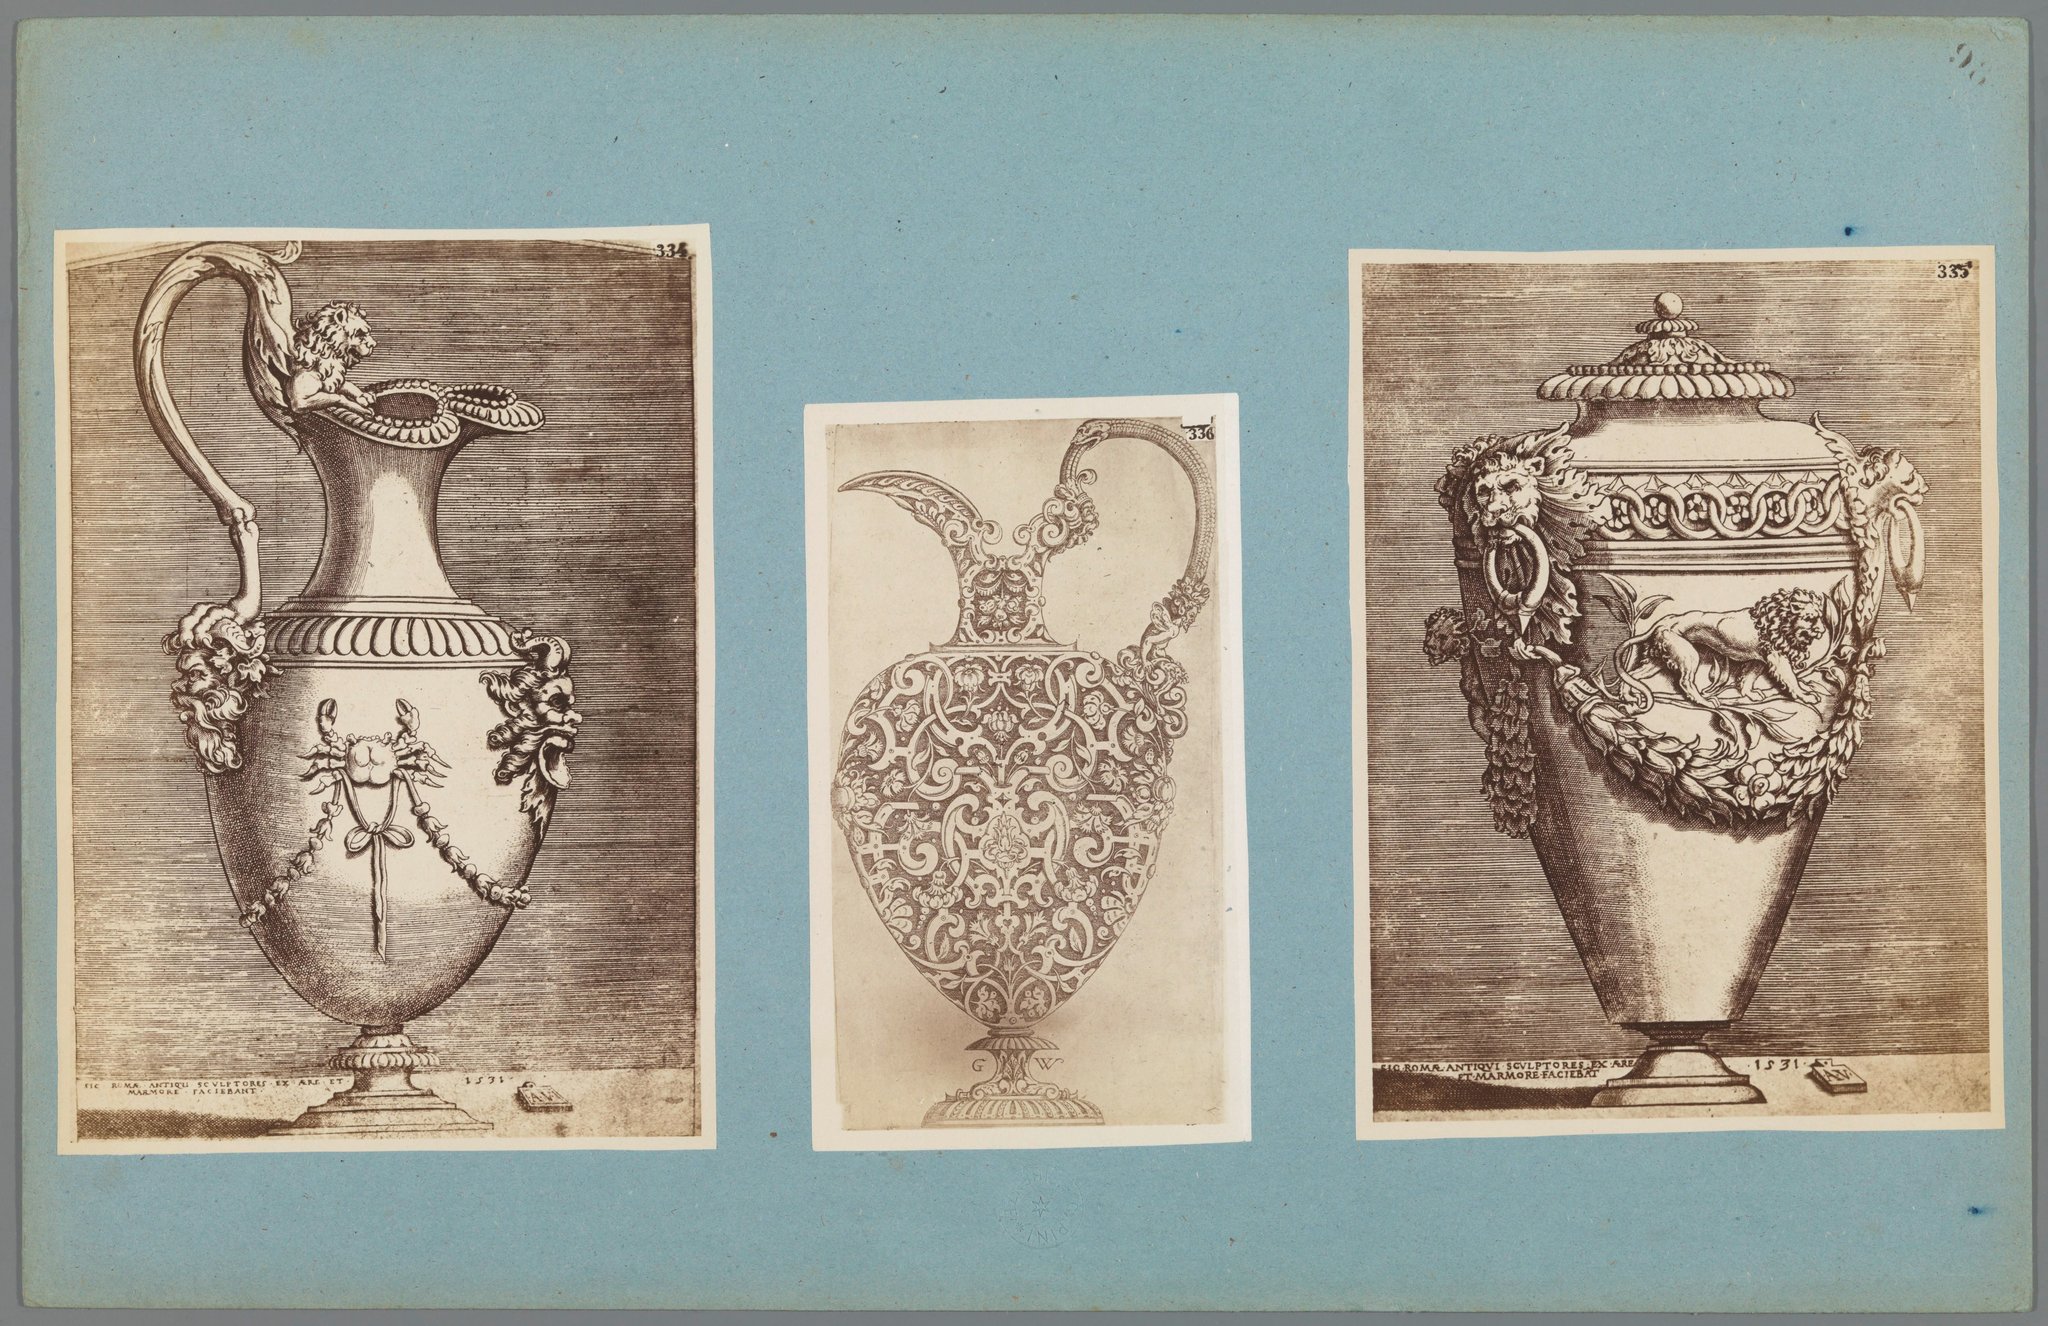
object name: reproduction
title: Drie fotoreproducties van prenten van vazen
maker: Anonymous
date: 1875-1900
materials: cardboard, photographic support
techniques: albumen print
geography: europe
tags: fantasy ornament, vase ~ ornament, crustaceans: crab, beasts of prey, predatory animals: lion, europe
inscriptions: number: ‘98’, number: ‘335’, collector's mark: Lugt 3937, number: ‘336’, name: ‘C. PINI FIRENZE’, number: ‘334.’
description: Links (334) een prent van een vaas met een leeuw en een krab, midden (336) een prent van een vaas met fantasieornament, rechts (335) een prent van een vaas met een leeuw en guirlandes.